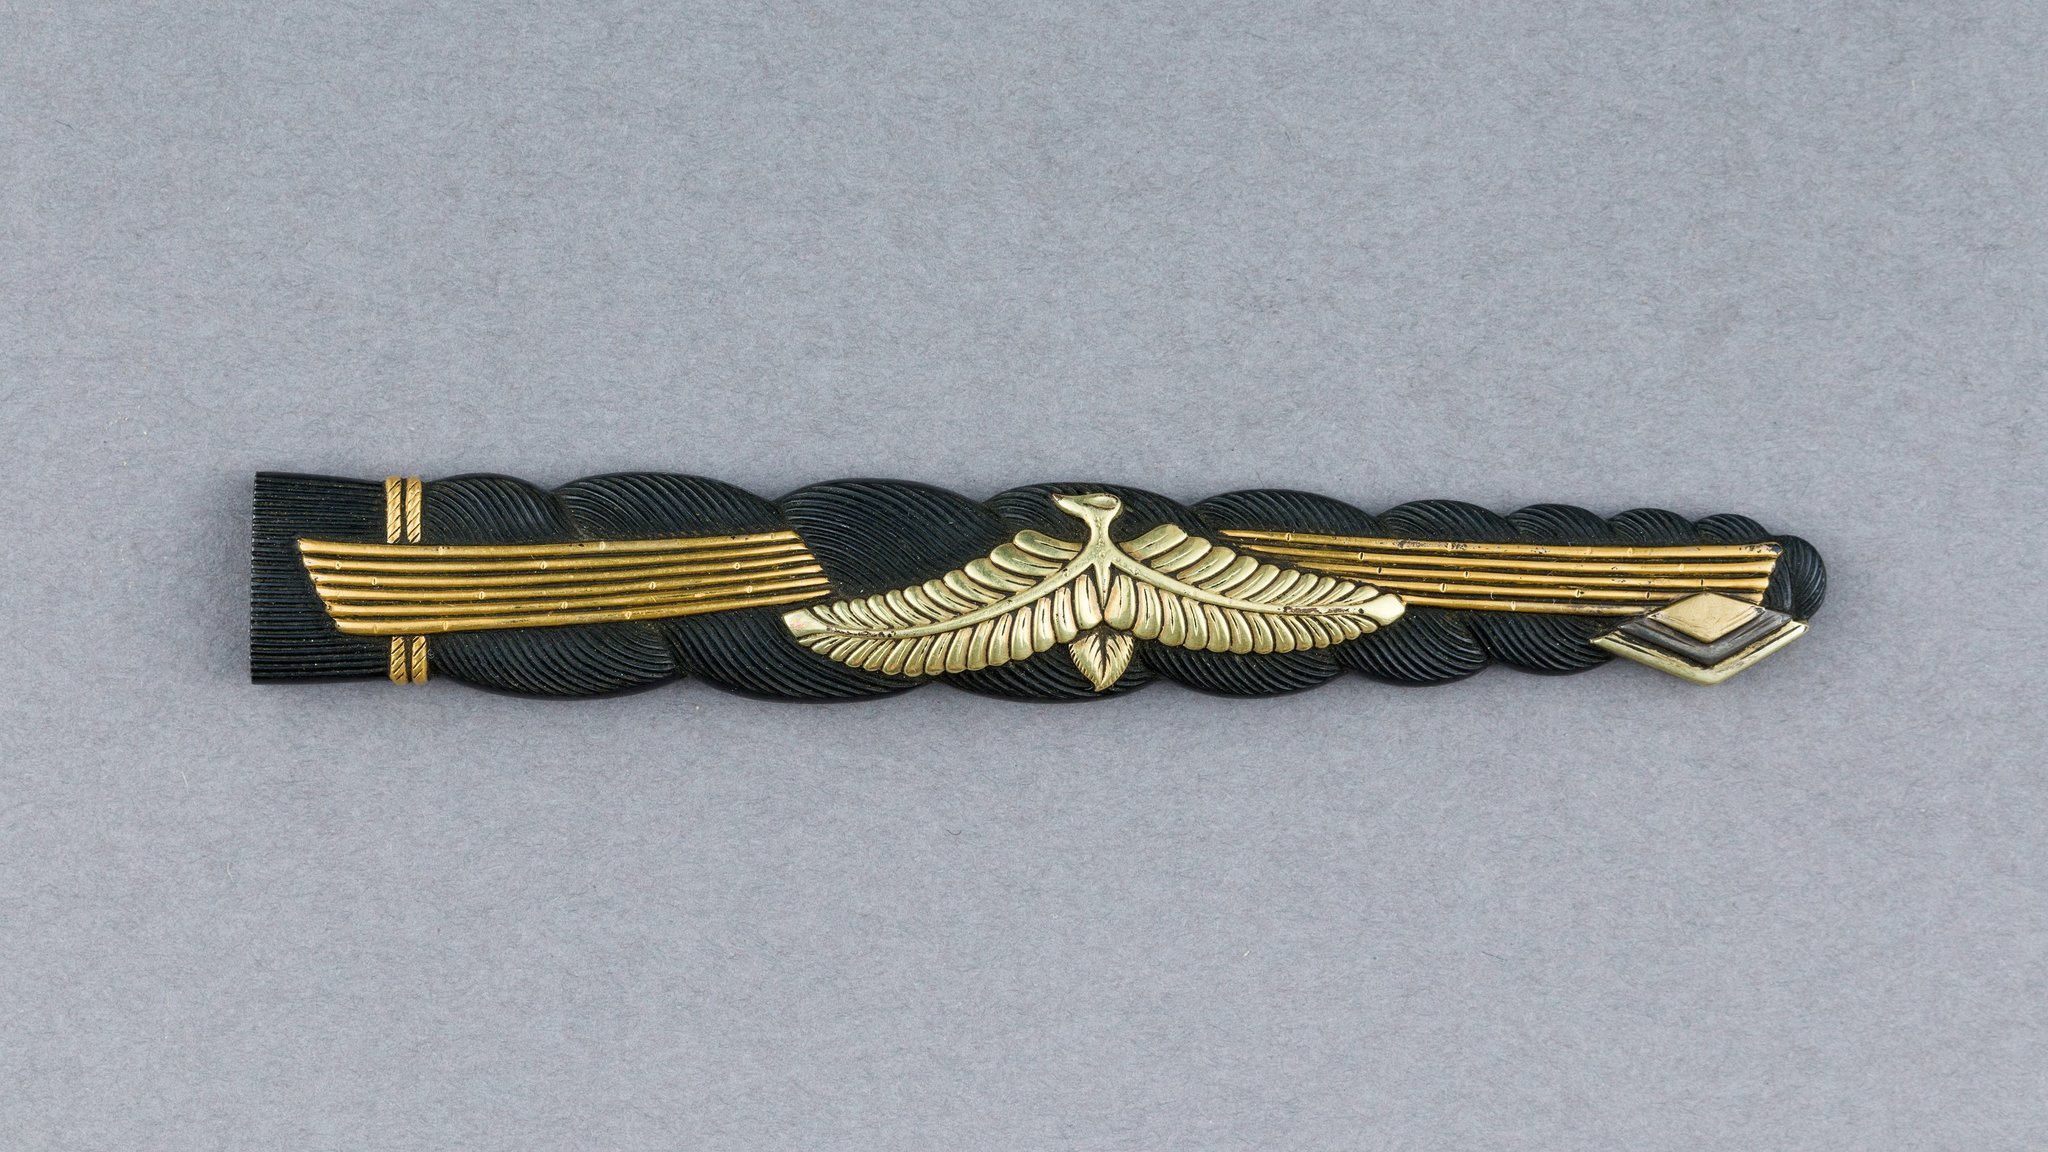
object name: knife handle kozuka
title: Knife Handle (Kozuka)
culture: japanese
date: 1615-1868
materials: gold alloy, gold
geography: japan